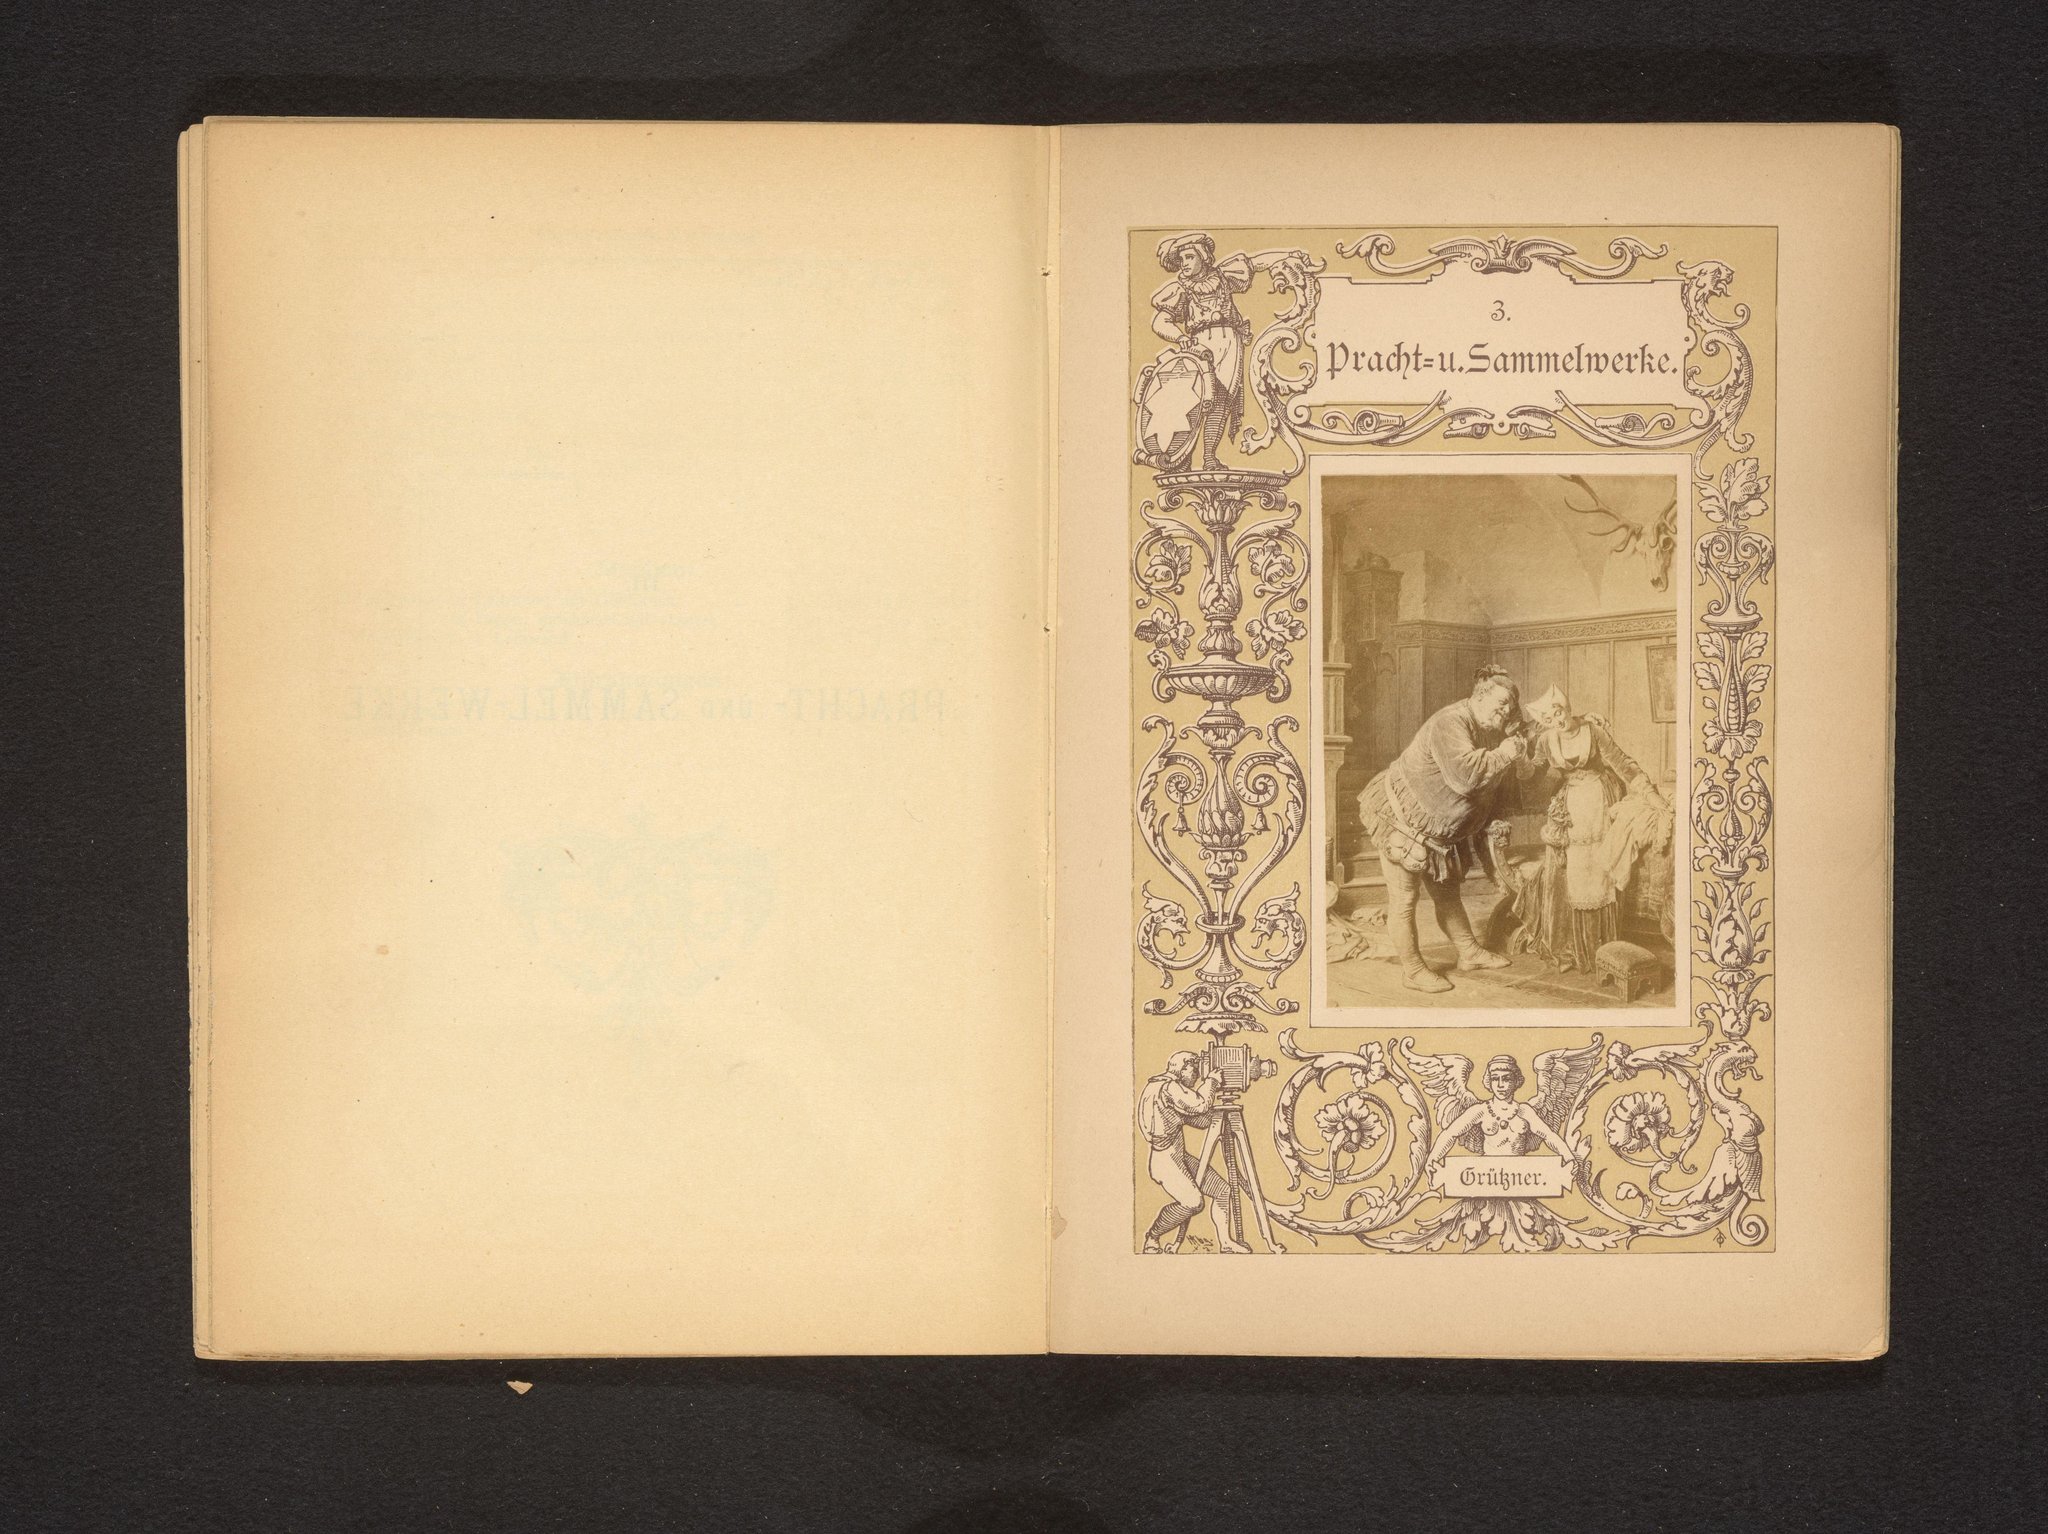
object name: page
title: Fotoreproductie van een schilderij door Eduard von Grützner, voorstellend een man en een vrouw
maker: eduard von grützner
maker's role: painter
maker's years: 1846-1925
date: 1871-1881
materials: photographic support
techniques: albumen print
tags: picture, painting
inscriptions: inscription: ‘3. Pracht=u. Sammelwerke.’